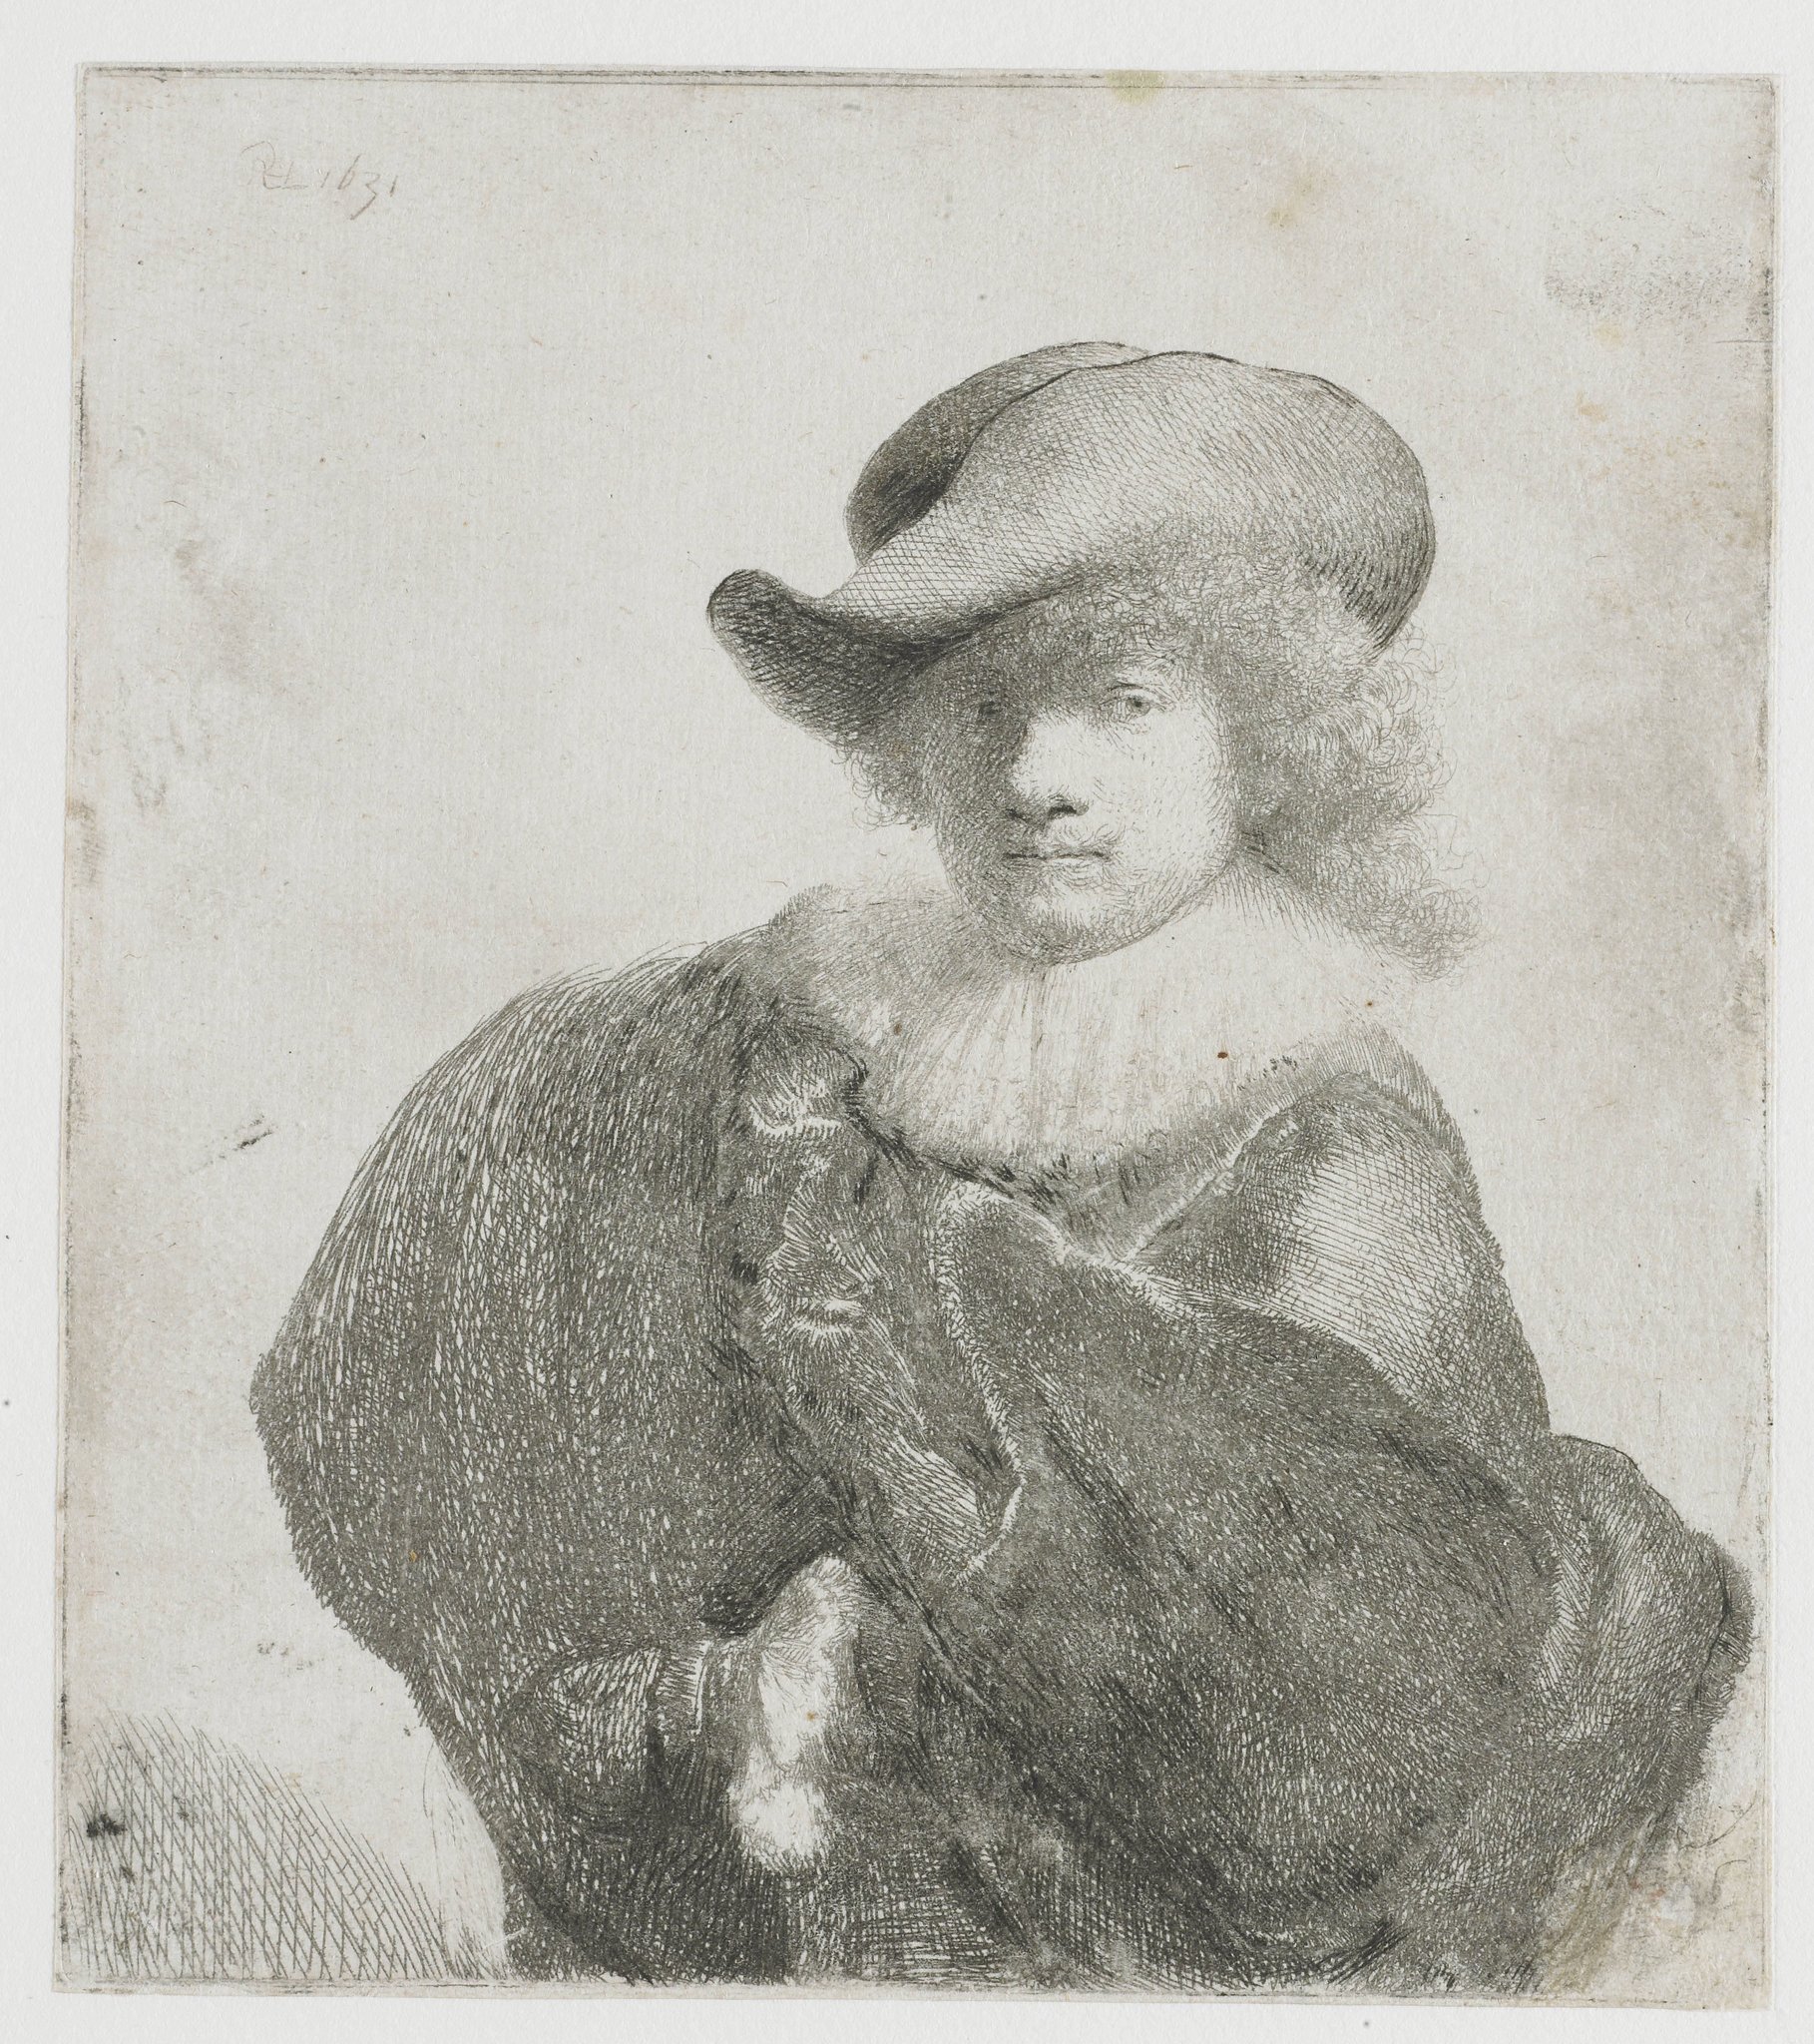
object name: print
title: Self-portrait in a Soft Hat and Patterned Cloak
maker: rembrandt van rijn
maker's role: draughtsman, painter, print maker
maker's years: 1606-1669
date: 1631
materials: ink, paper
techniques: drypoint, etching, pen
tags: leiden, amsterdam, painter, print maker, draughtsman, rembrandt van rijn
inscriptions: monogram and date: ‘RHL 1631’, collector's mark: Lugt 240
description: Rembrandt’s etchings rarely came into being in a single session. Certainly in the early years when he was still inexperienced, several steps were needed to achieve the results he had in mind. This self-portrait shows how he went about this. He began with the head, moved on to the torso and finally added the background.